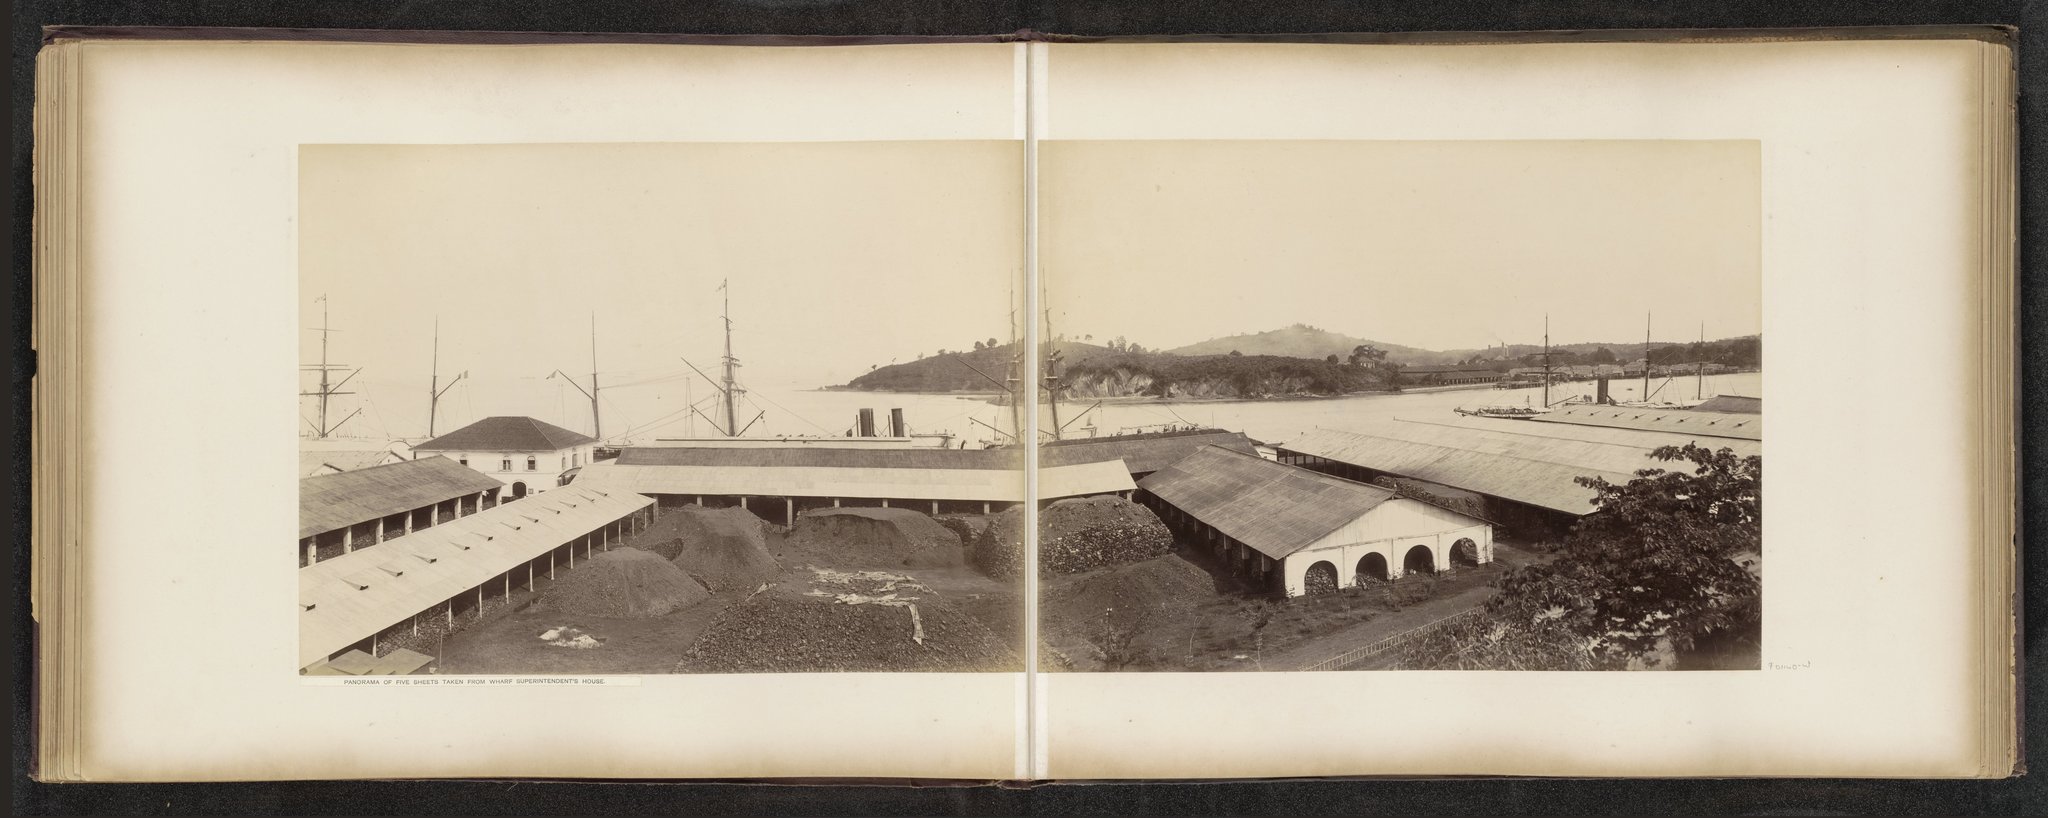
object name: panoramic photograph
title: Panorama of five sheets taken from wharf superintendent's house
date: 1890-1905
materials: photographic support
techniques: albumen print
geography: singapore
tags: pier, quay, wharf, shipyard, shipdock, shipbuilding industry, singapore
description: Panorama bestaande uit vijf afdrukken. Onderdeel van Fotoalbum van de Tanjong Pagar Dock Co. Ltd. in Singapore.